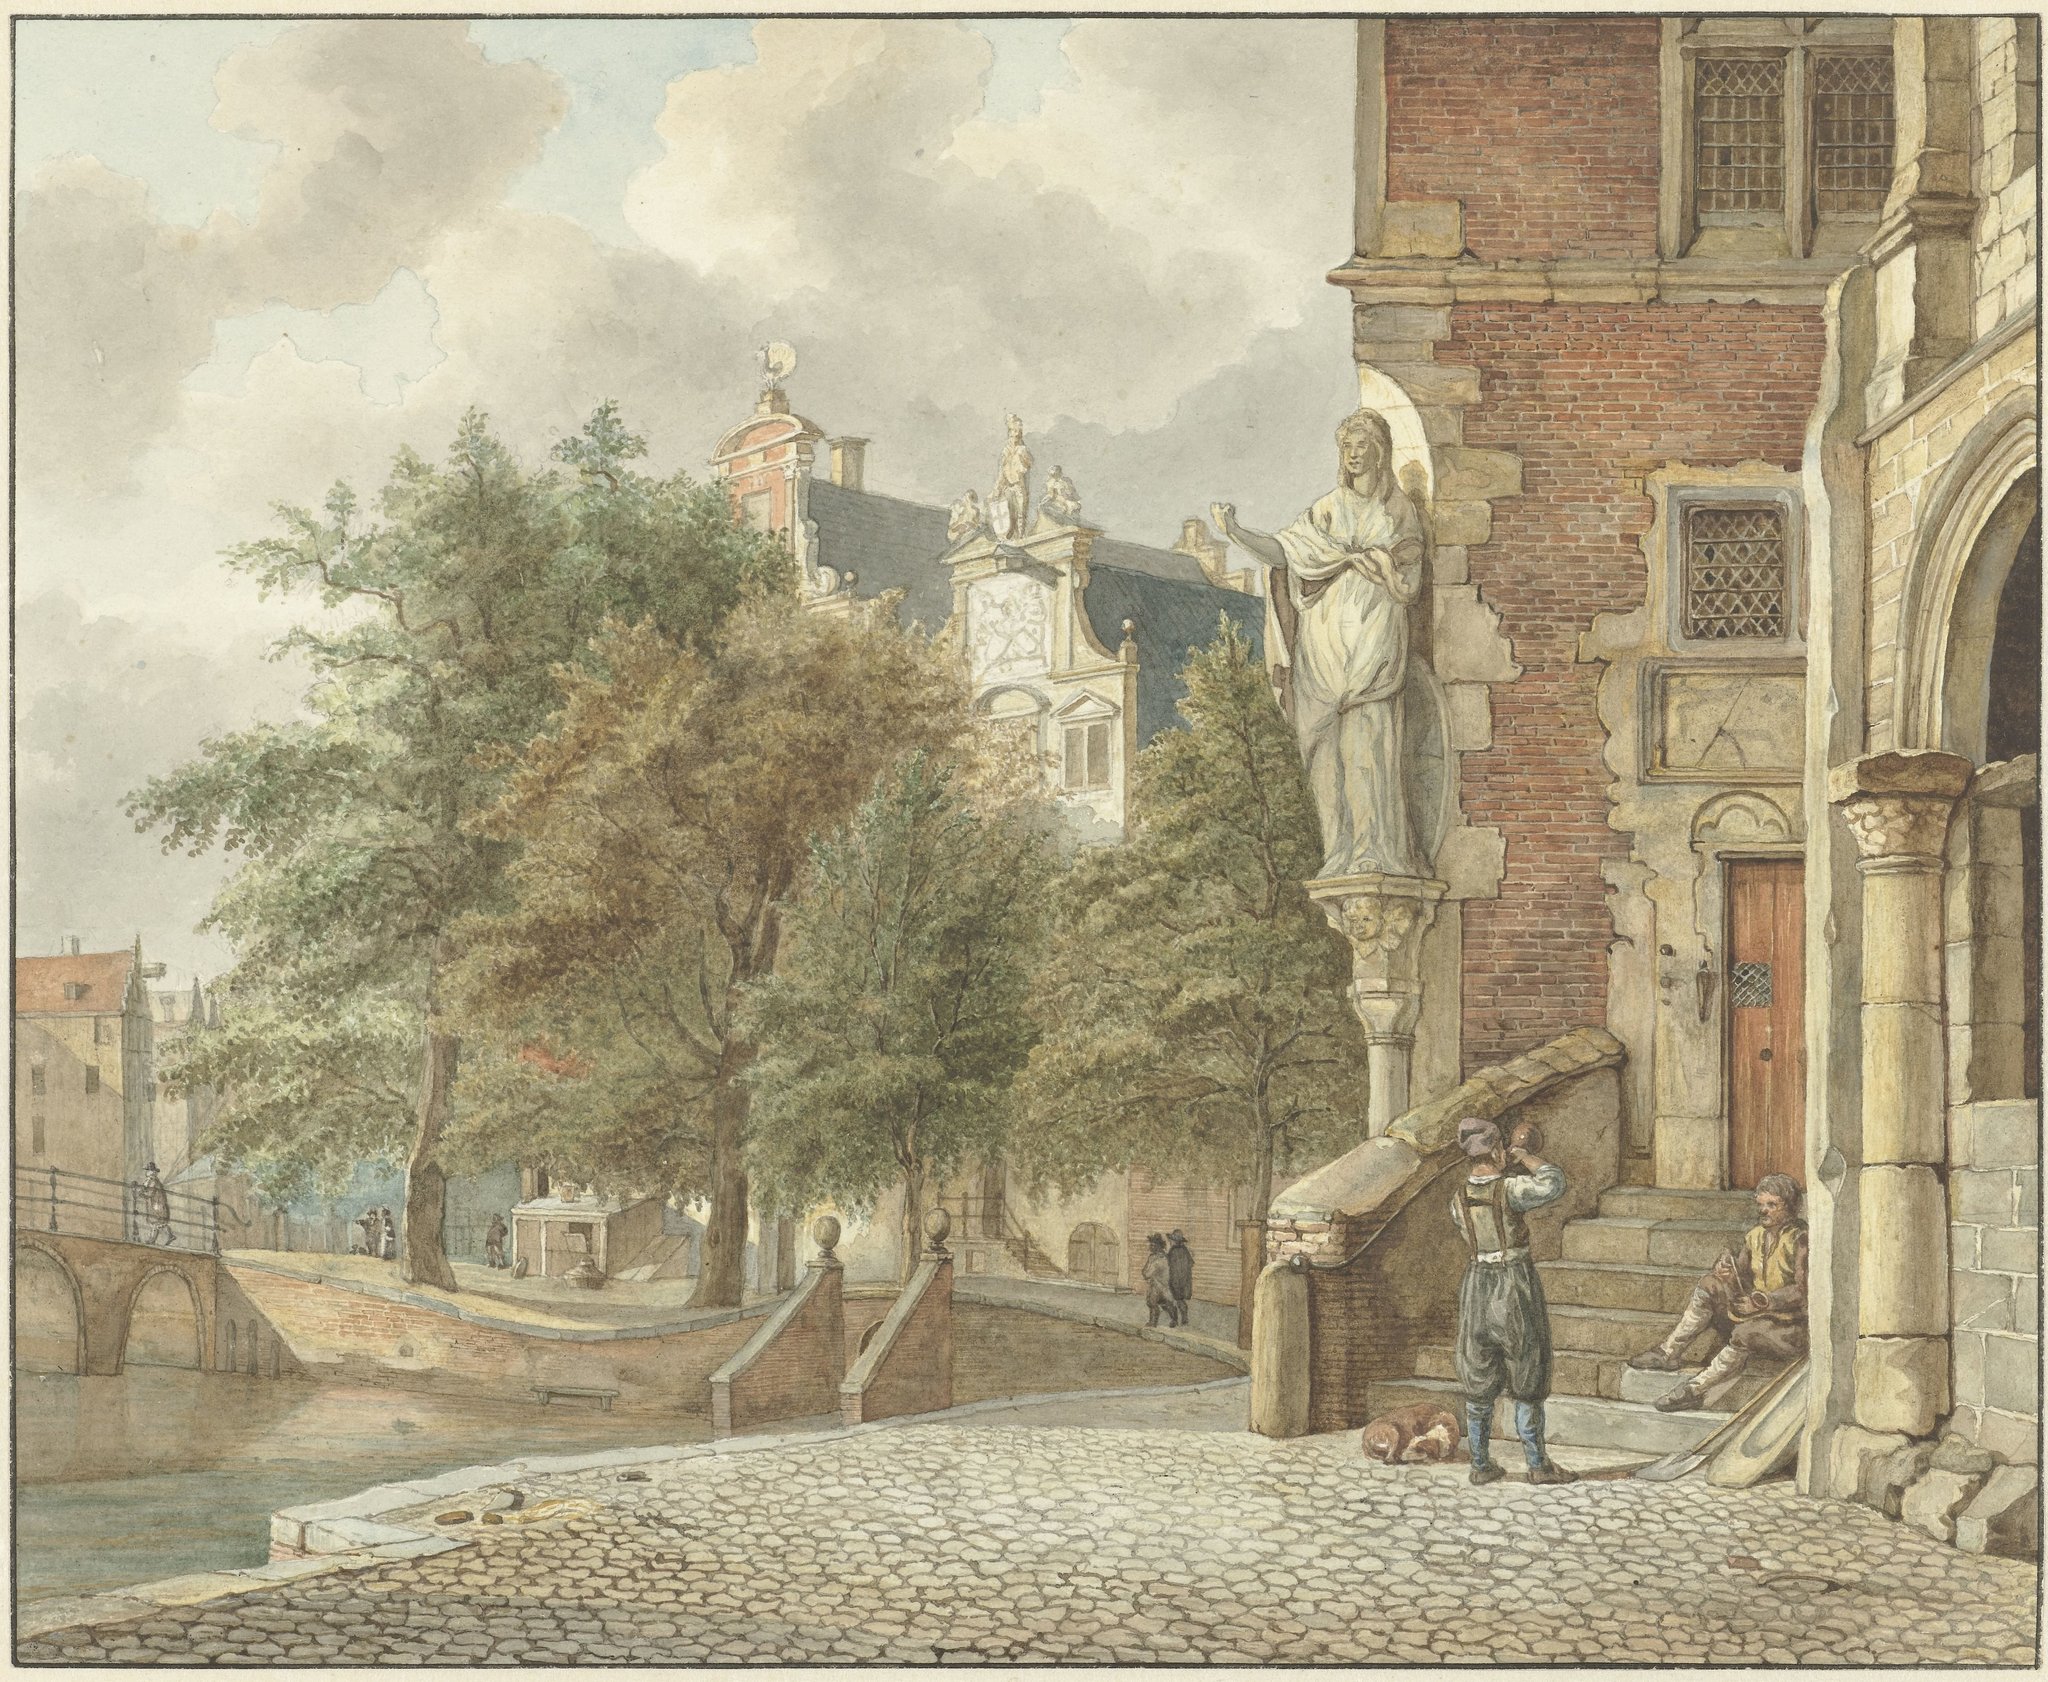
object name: watercolor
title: Gezicht op een stadsgracht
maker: reinier vinkeles (i)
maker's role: draughtsman, print maker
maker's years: 1741-1816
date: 1801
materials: paper, watercolor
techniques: brush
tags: village, street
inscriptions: inscription: ‘R. Vinkeles de jonge, del: 1801./ naar een schilderij van J. vander Heyde’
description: Gezicht op een stadsgracht, rechts een beeld in een nis en een gotisch gebouw.